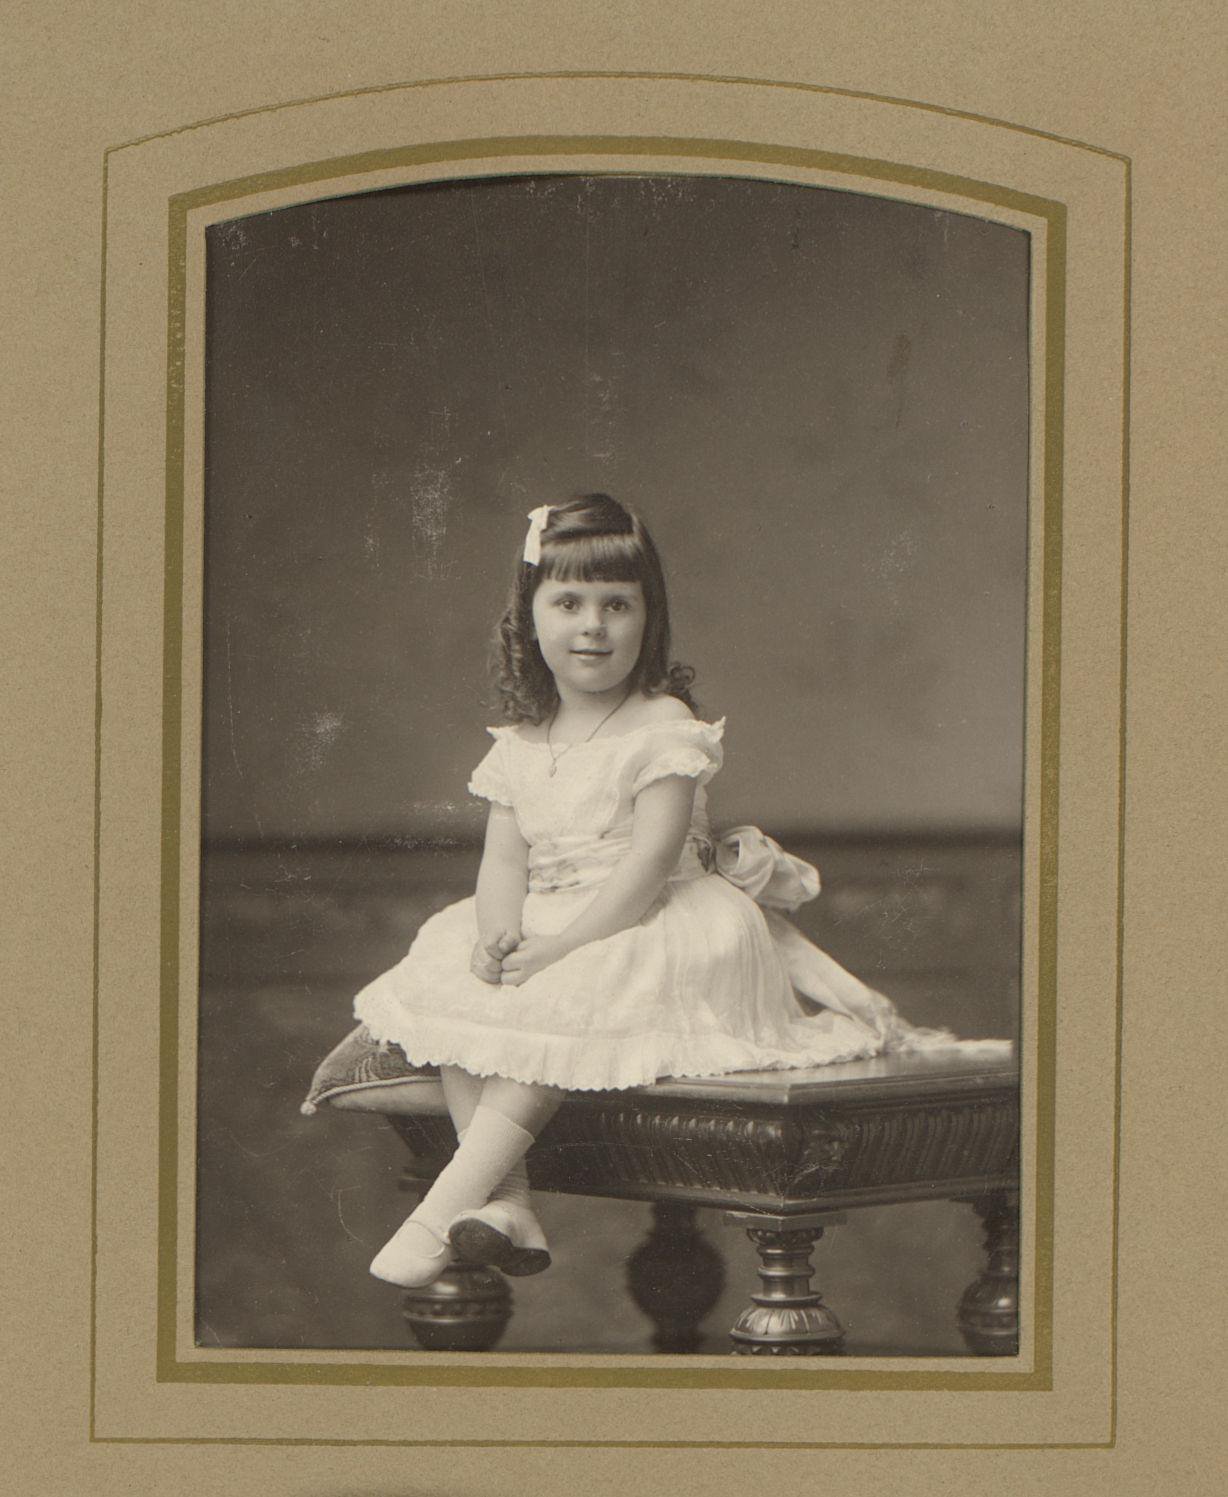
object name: photograph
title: Portret van een onbekend meisje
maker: Anonymous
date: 1895-1920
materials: cardboard, photographic support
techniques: matte daylight collodion silver print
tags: toddler (female), historical persons not known by name